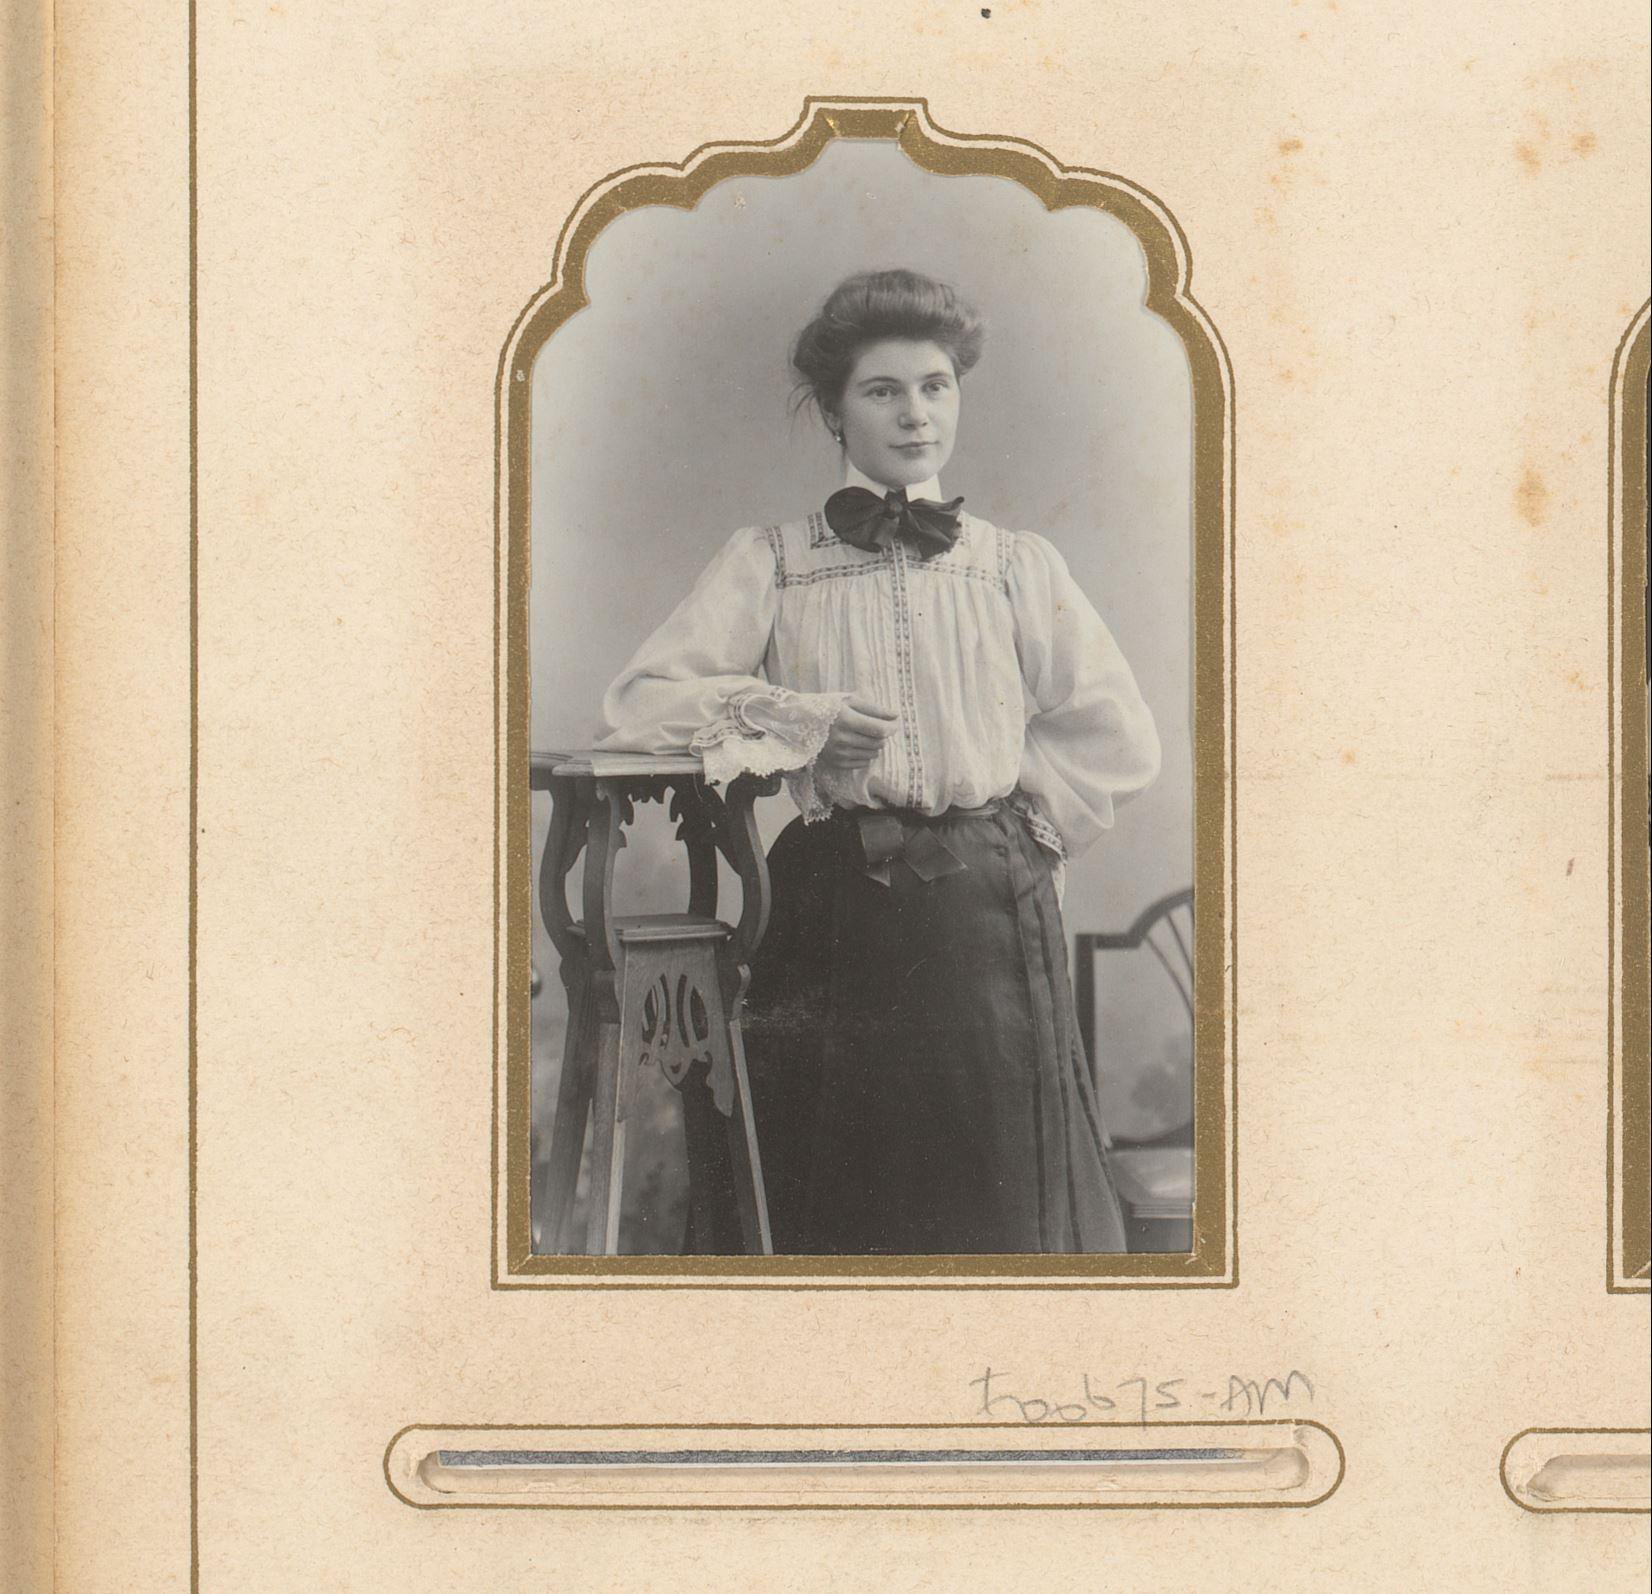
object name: photograph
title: Portret van een staande jonge vrouw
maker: ch.j.h. van waegeningen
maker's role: fotograaf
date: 1890-1930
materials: cardboard, photographic support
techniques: collodion silver print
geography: roermond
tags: adolescent, young woman, maiden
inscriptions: inscription: ‘Ch. J.H. van Waegeningh/ Roermond Willem II Singel 70’